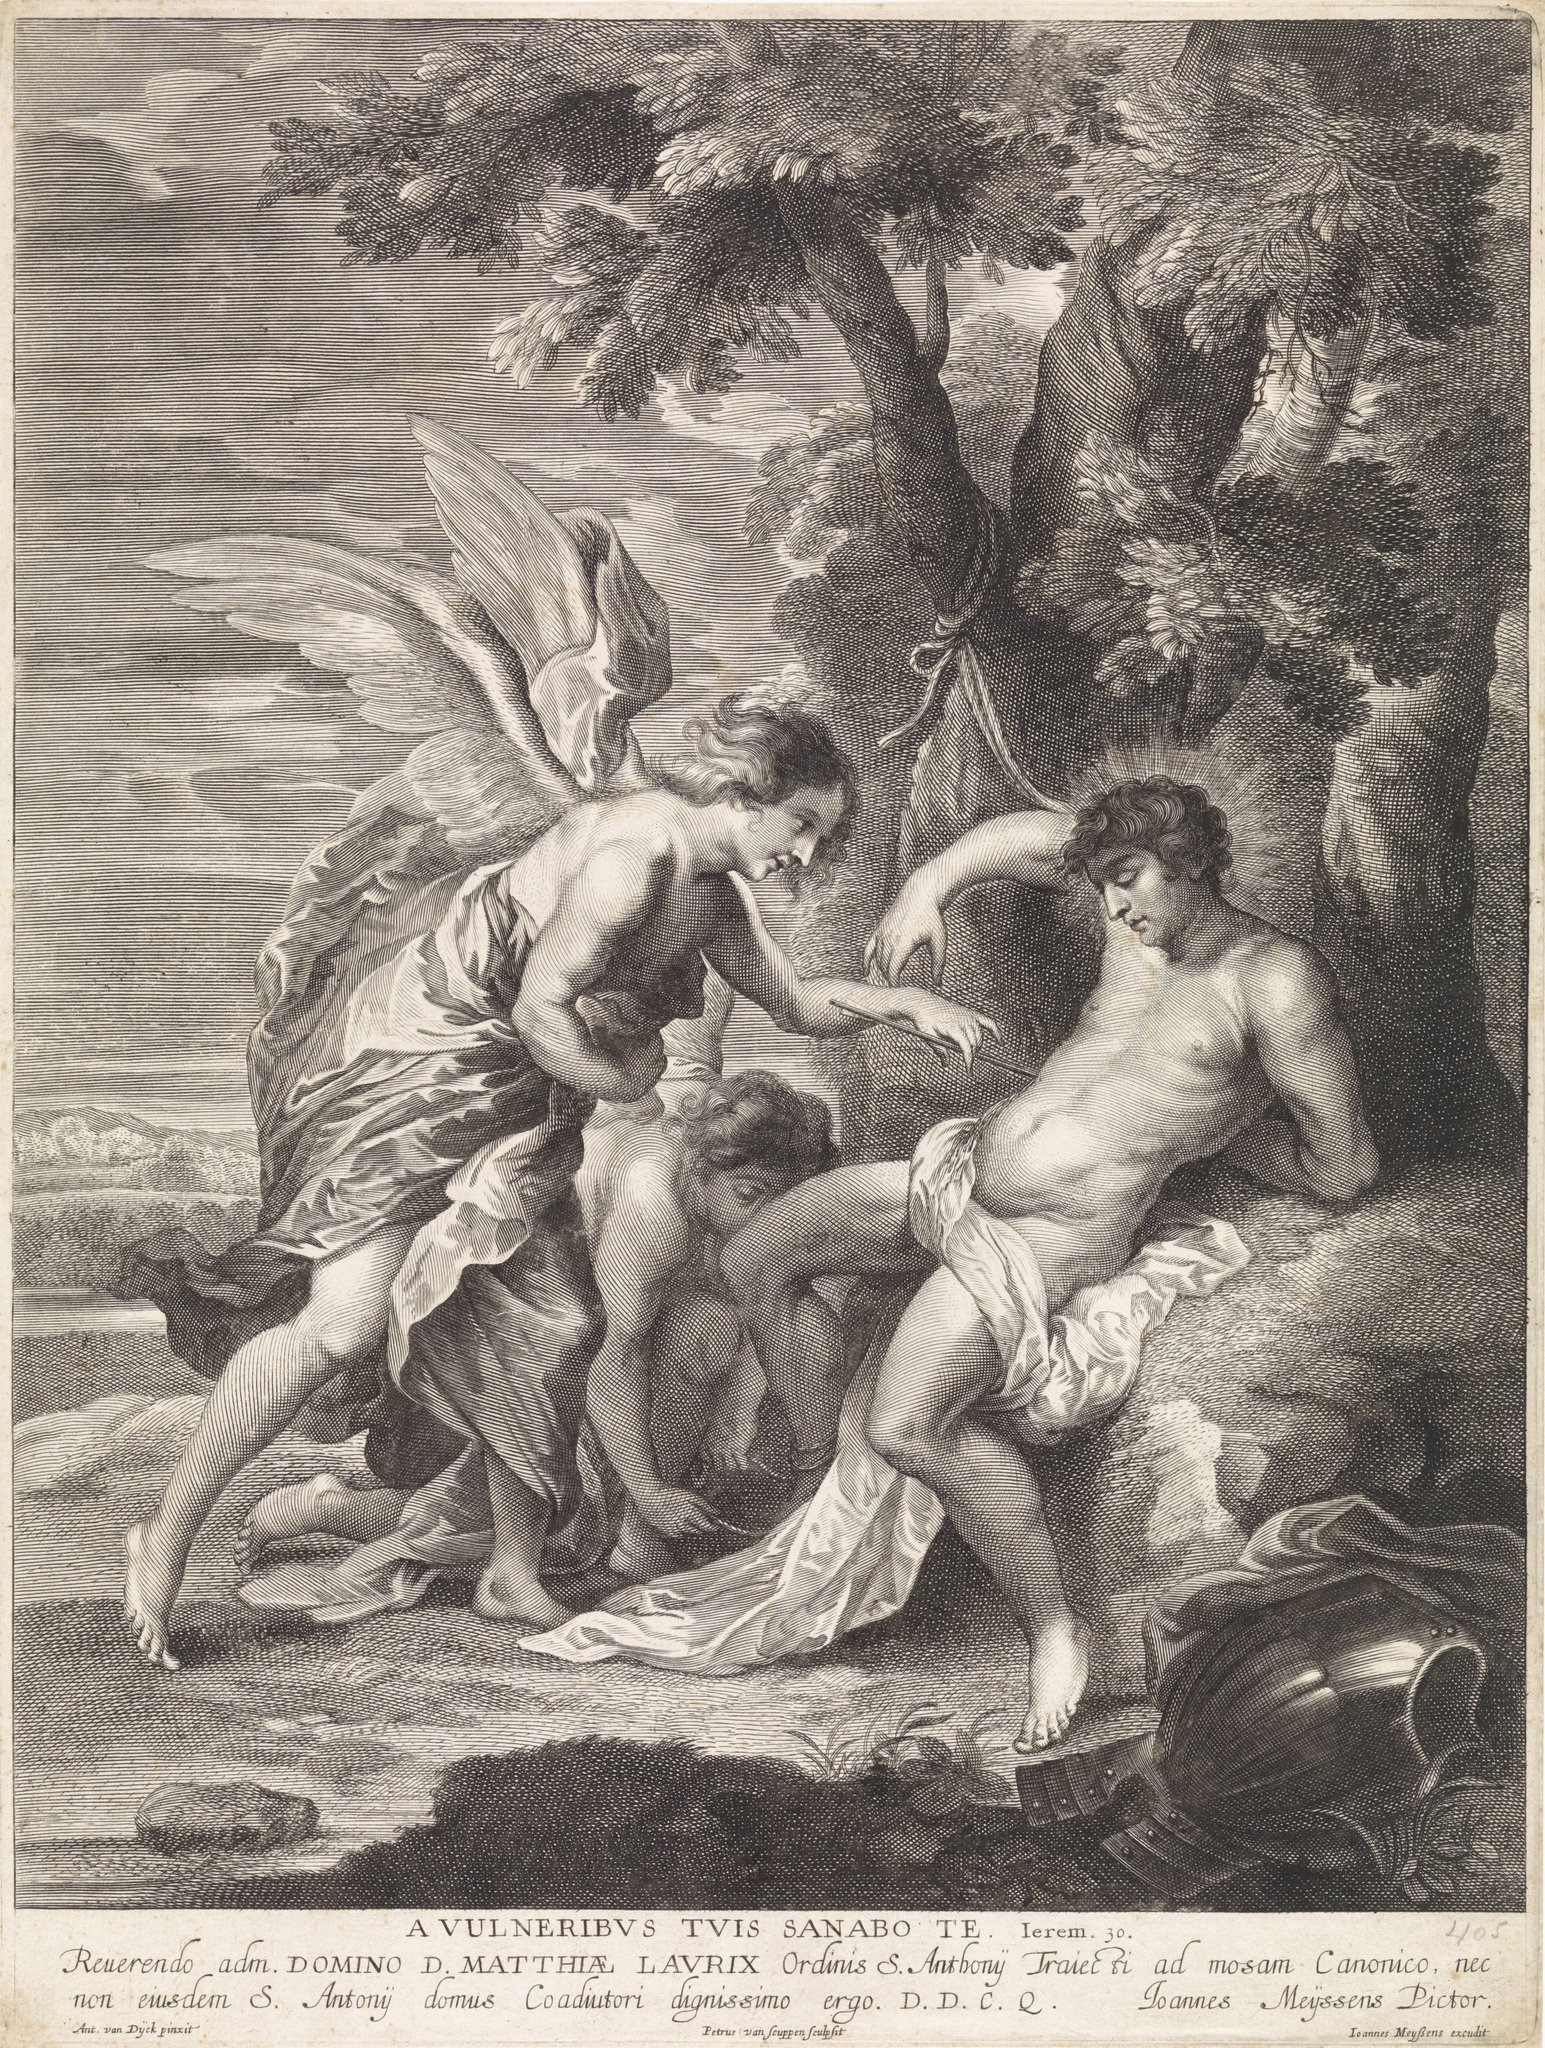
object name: print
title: H. Sebastiaan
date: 1638-1670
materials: paper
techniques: engraving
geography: maastricht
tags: st. sebastian succoured by angels, who untie him from the tree or pillar and remove the arrows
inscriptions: collector's mark: Lugt 2228, collector's mark: Lugt 3200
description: De heilige Sebastiaan zit vastgebonden aan een boom. Twee engelen bevrijden hem van zijn boeien en halen een pijl uit zijn lichaam. Op de grond liggen het harnas en de mantel van Sebastiaan. In de marge een Bijbeltekst uit Jer. 30 en een opdracht aan de Maastrichtse Kannunik Matthias Laurix.